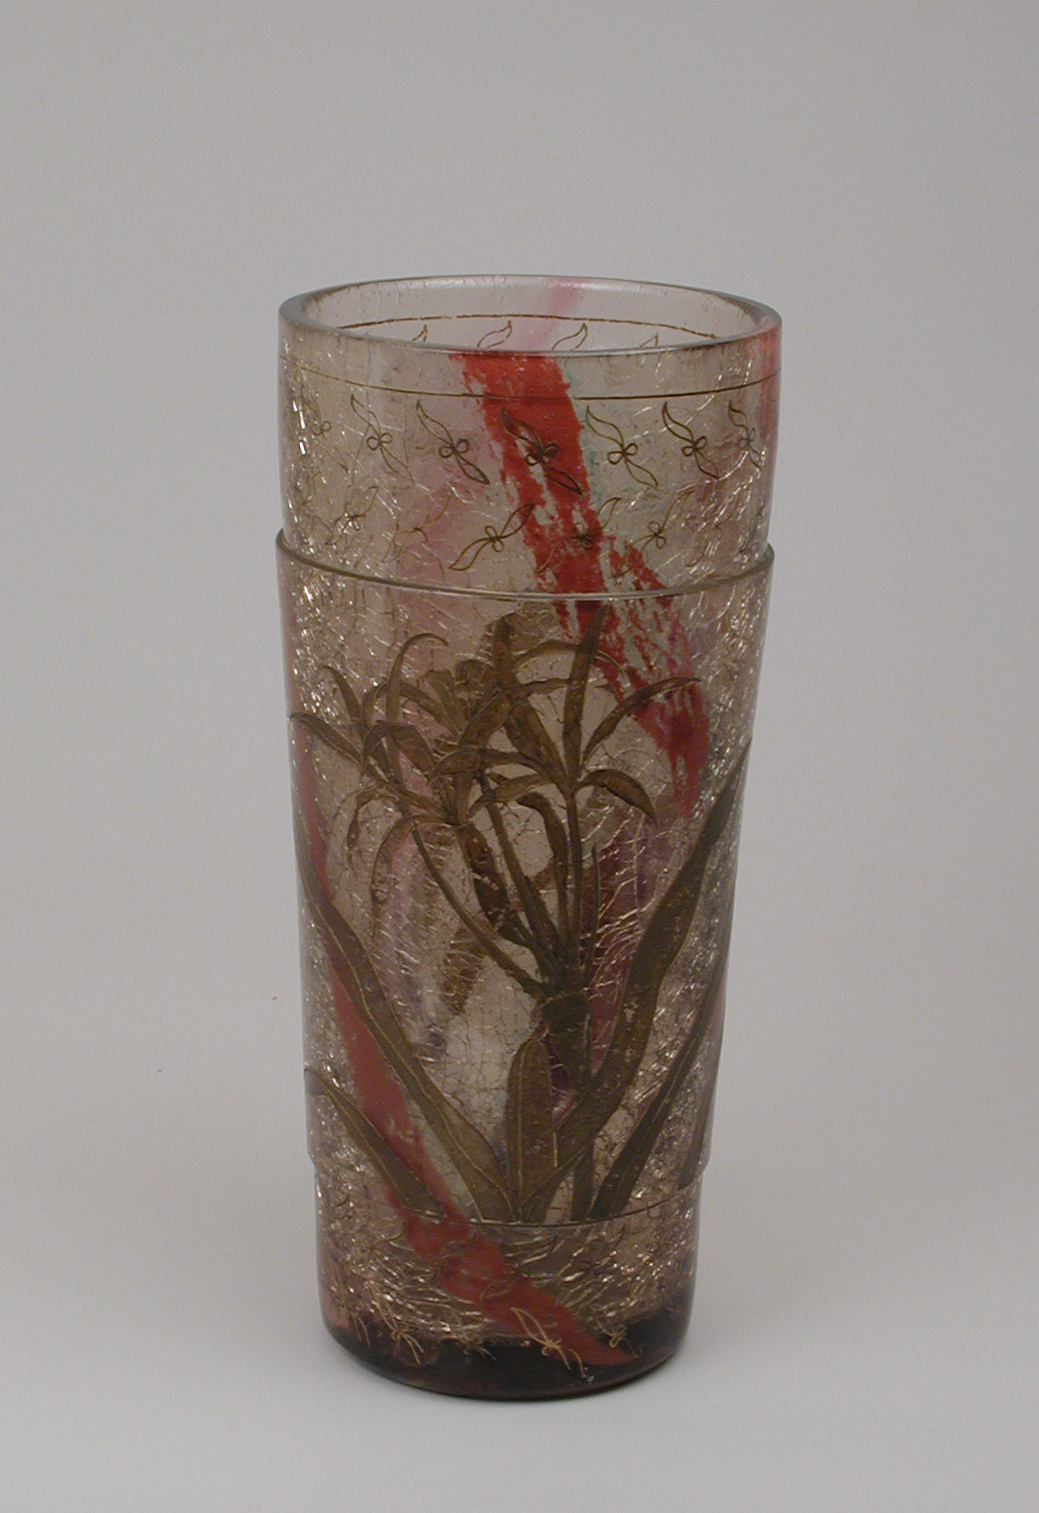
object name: vase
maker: françois eugène rousseau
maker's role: maker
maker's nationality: french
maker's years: 1827-1891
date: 1870-1880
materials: glass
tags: plants